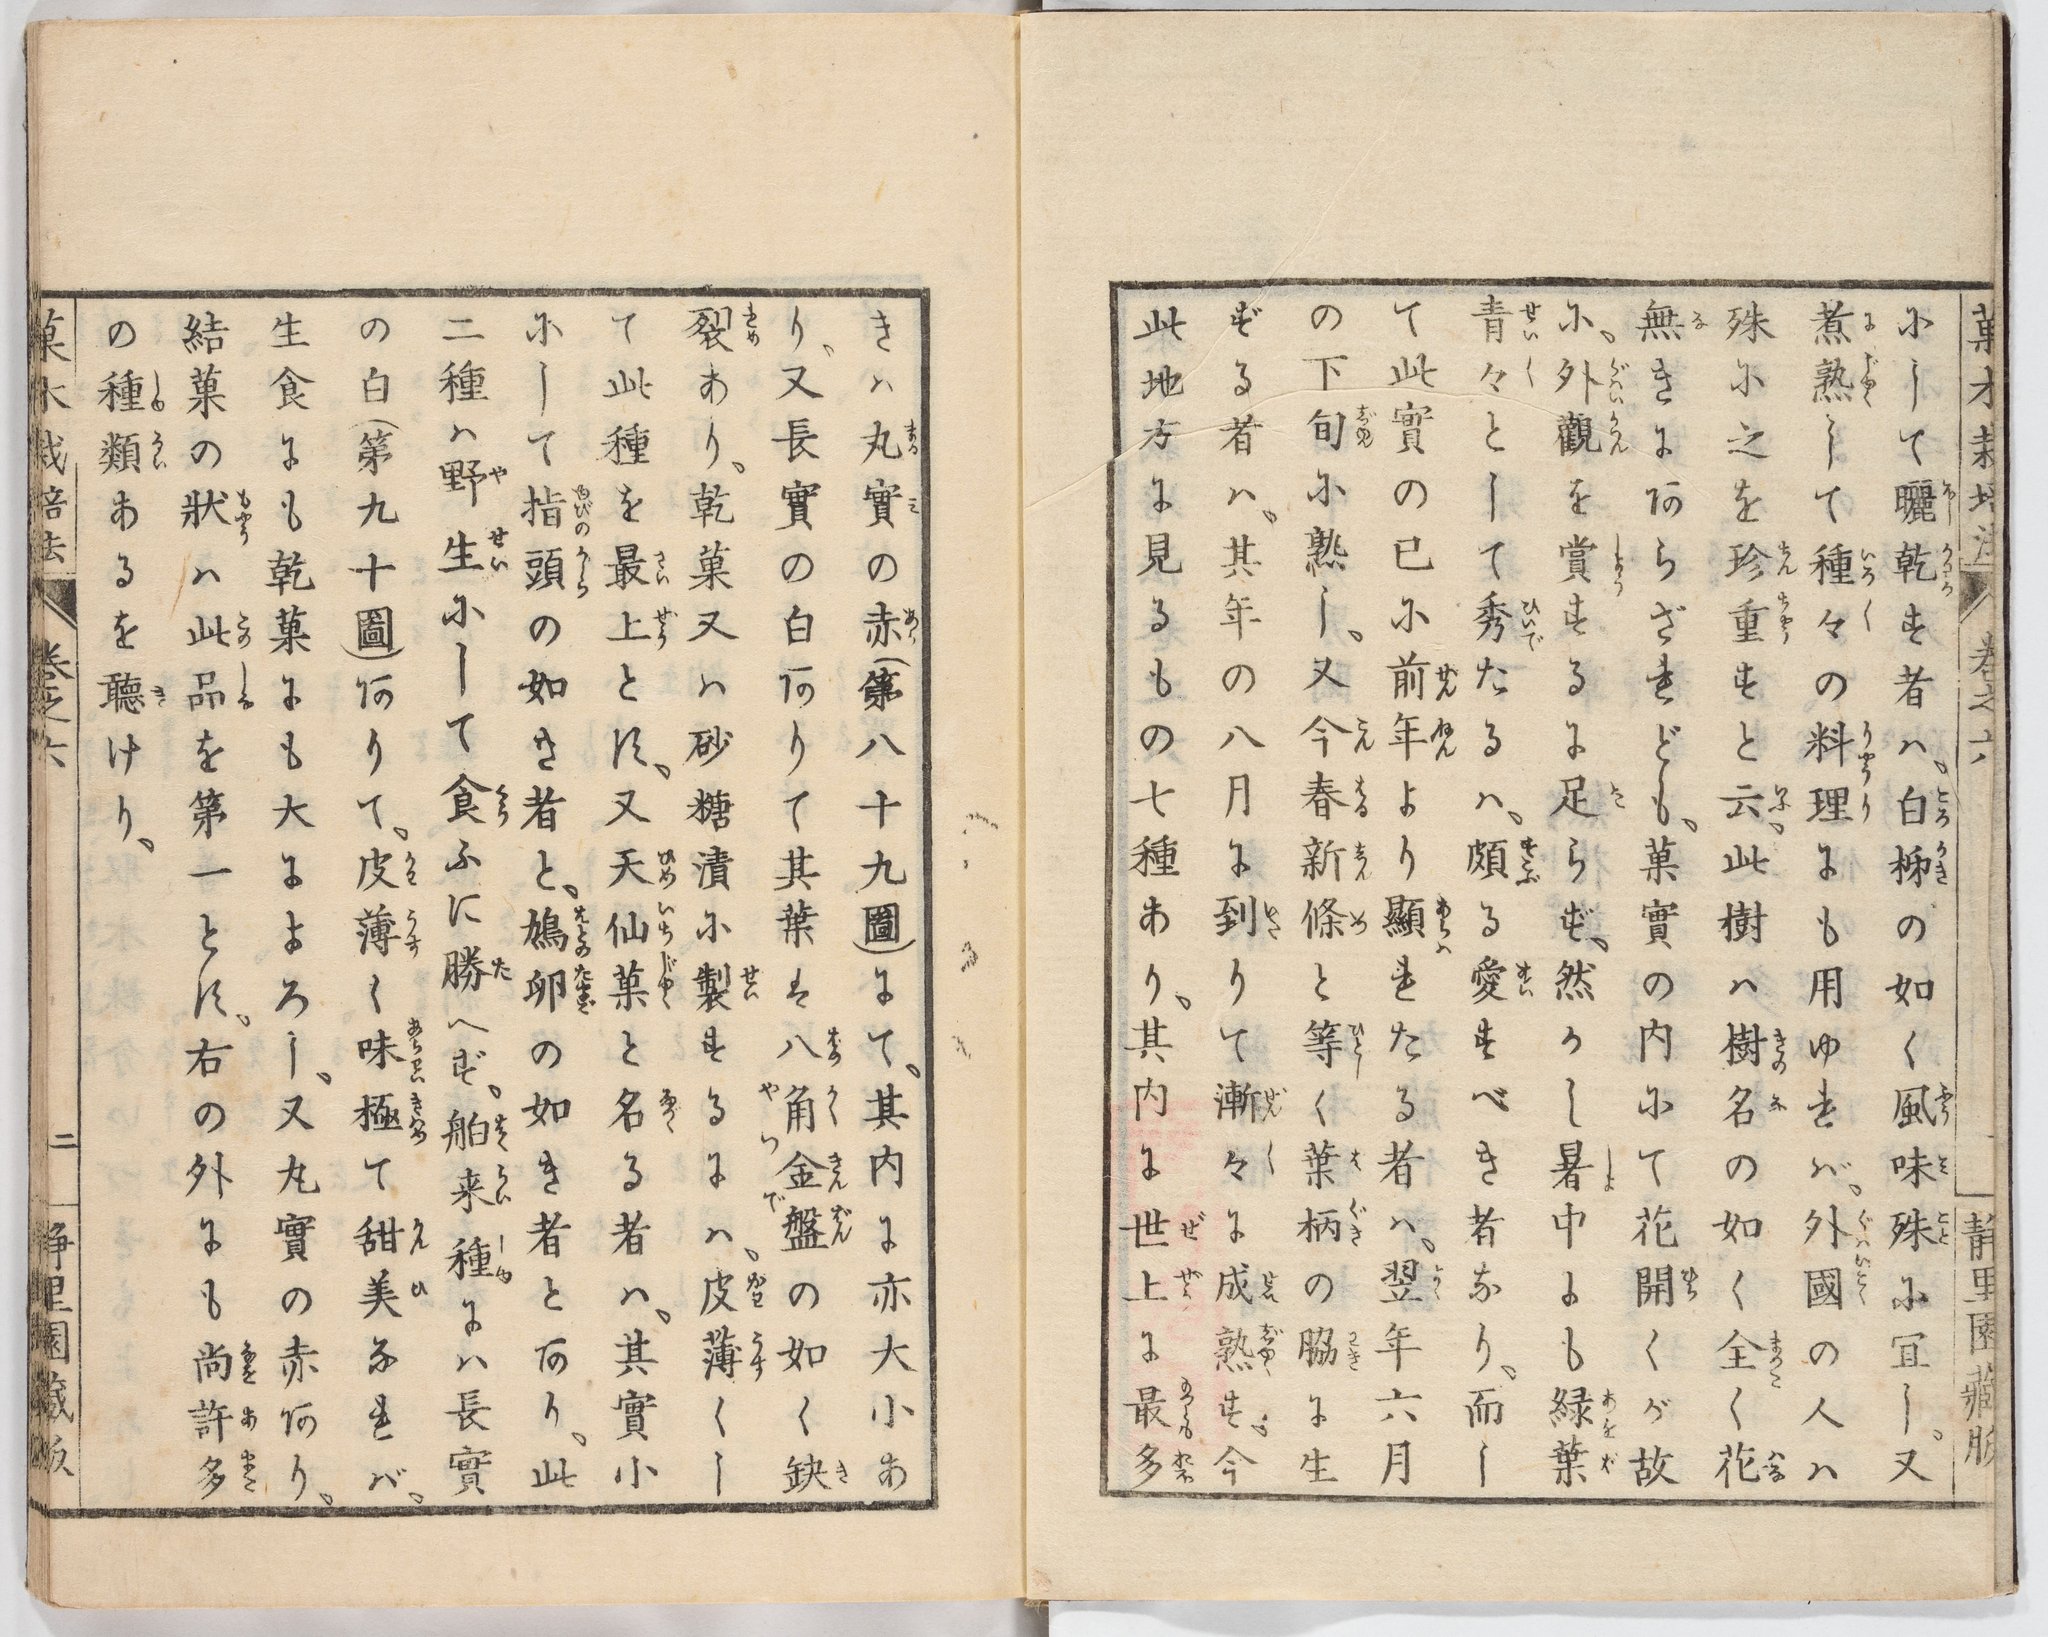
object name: illustrated book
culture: japanese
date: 1893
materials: ink, paper